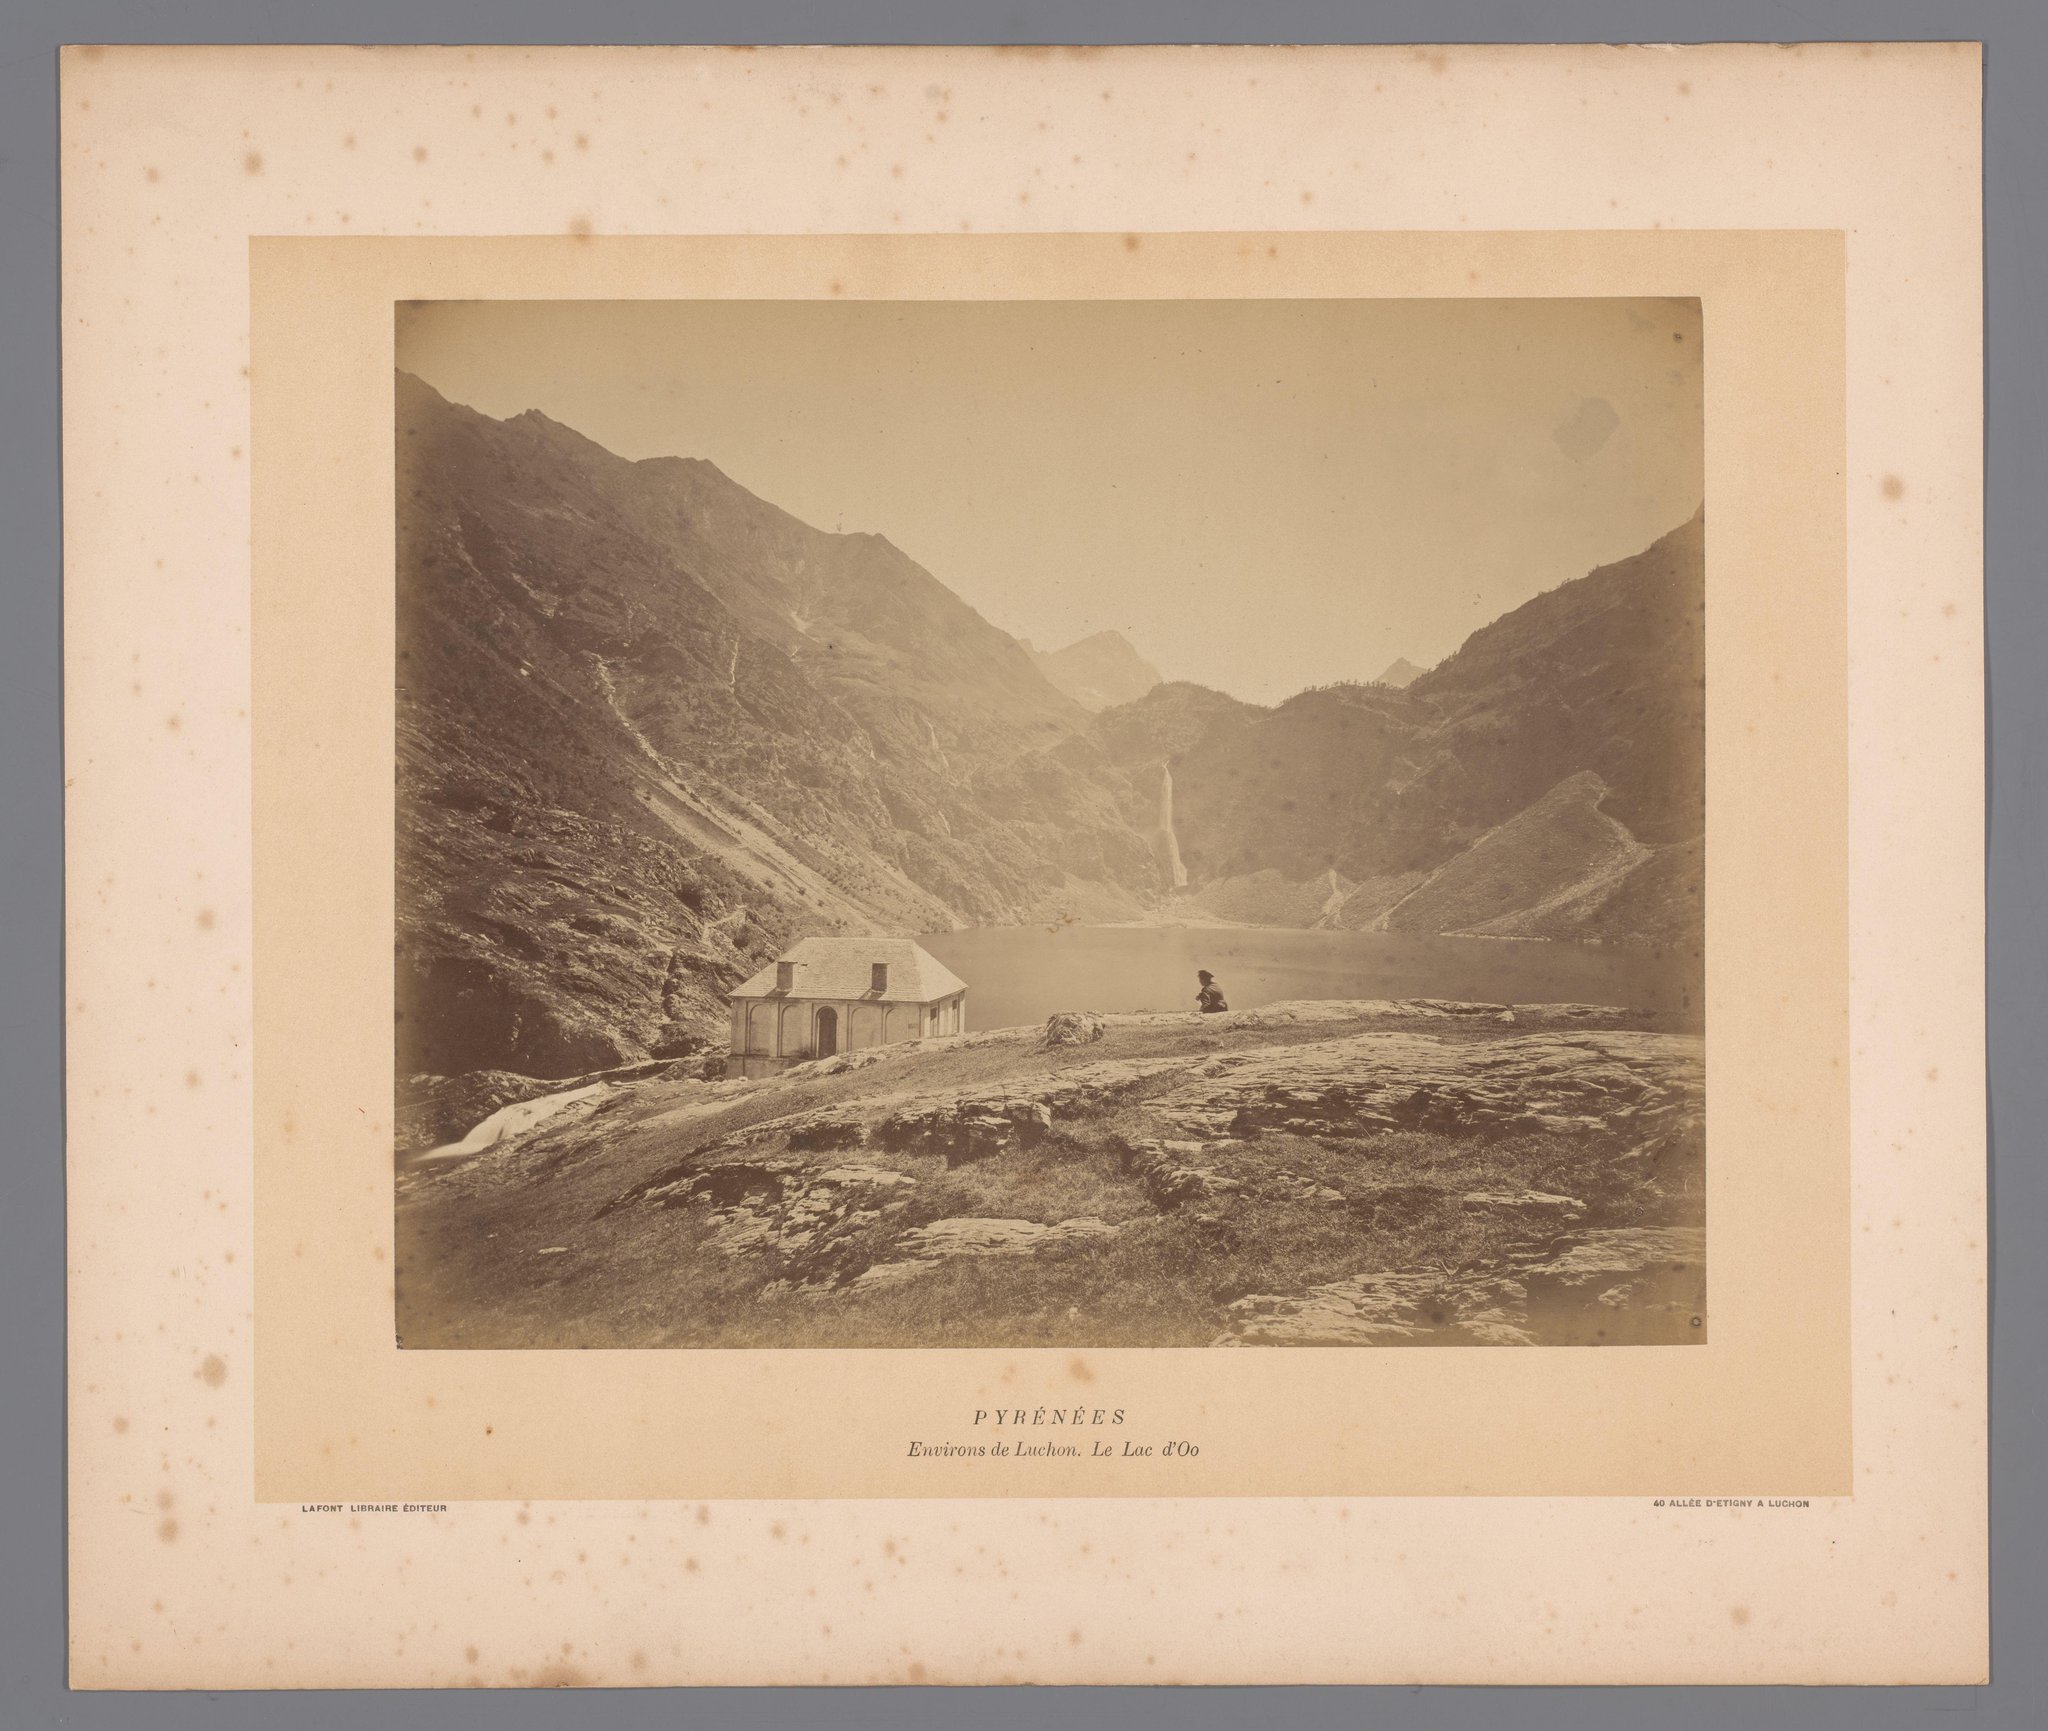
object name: photograph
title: "PYRÉNÉES Environs de Lachon, Le Lac D'Oo", Pyréneeën bij Lachon, Frankrijk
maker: Anonymous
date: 1884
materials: cardboard, paper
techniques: albumen print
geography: luchon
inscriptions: caption: ‘LAFONT, LIBRAIRE ÉDITEUR//40, ALLÉE D'ETIGNY A LUCHON’, date: ‘15 October 1884.’, caption: ‘PYRÉNÉES//Environs de Lachon. Le Lac D'Oo’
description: Gezicht op het meer Lac d'Oo, met een waterval en een huis links op de voorgrond. Er zit een man op een heuvel met de rug naar de beschouwer over het meer uit te kijken. Luchon, Frankrijk